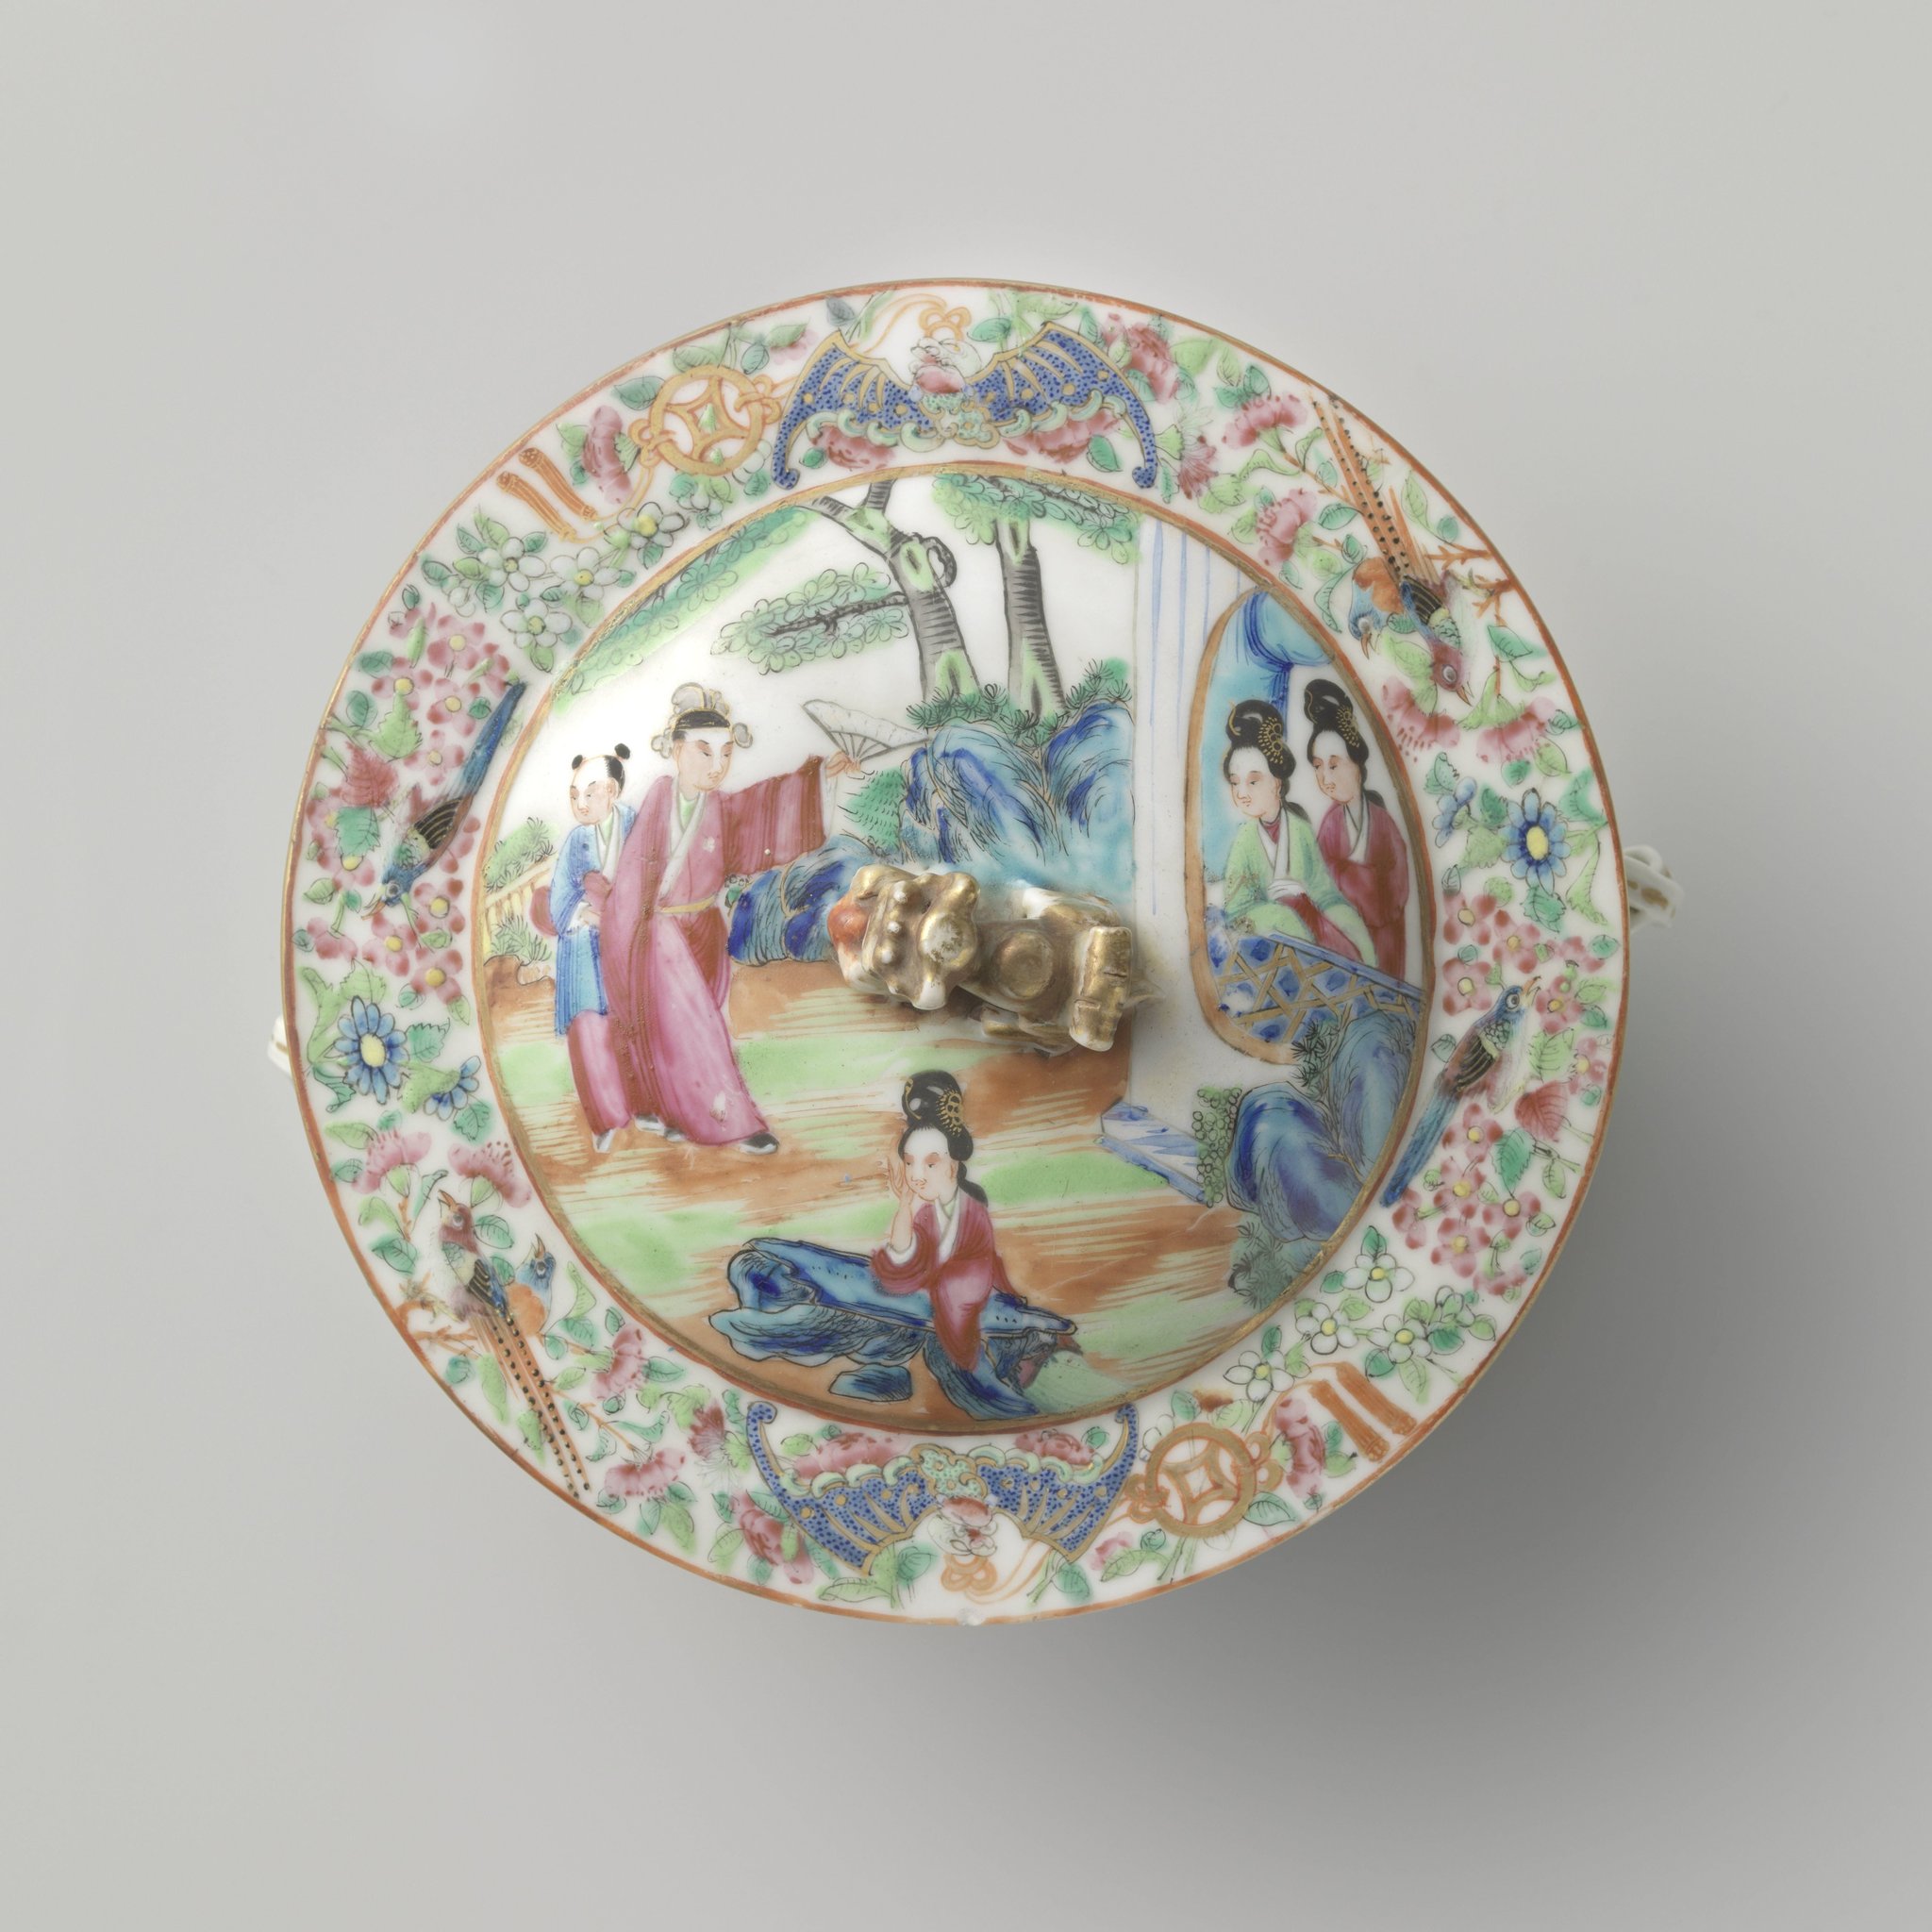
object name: lid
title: Tureen with stand with figures on a terras near a pavilion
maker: Anonymous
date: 1800-1849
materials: glaze, gold, paint, porcelain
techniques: firing, forming, gilding, turning, vitrification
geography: china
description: Deksel van terrine van porselein met twee gevlochten oren, beschilderd op het glazuur in blauw, rood, roze, groen, geel, zwart en goud. Dekselknop in de vorm van een shishi (leeuwhond). Famille rose.